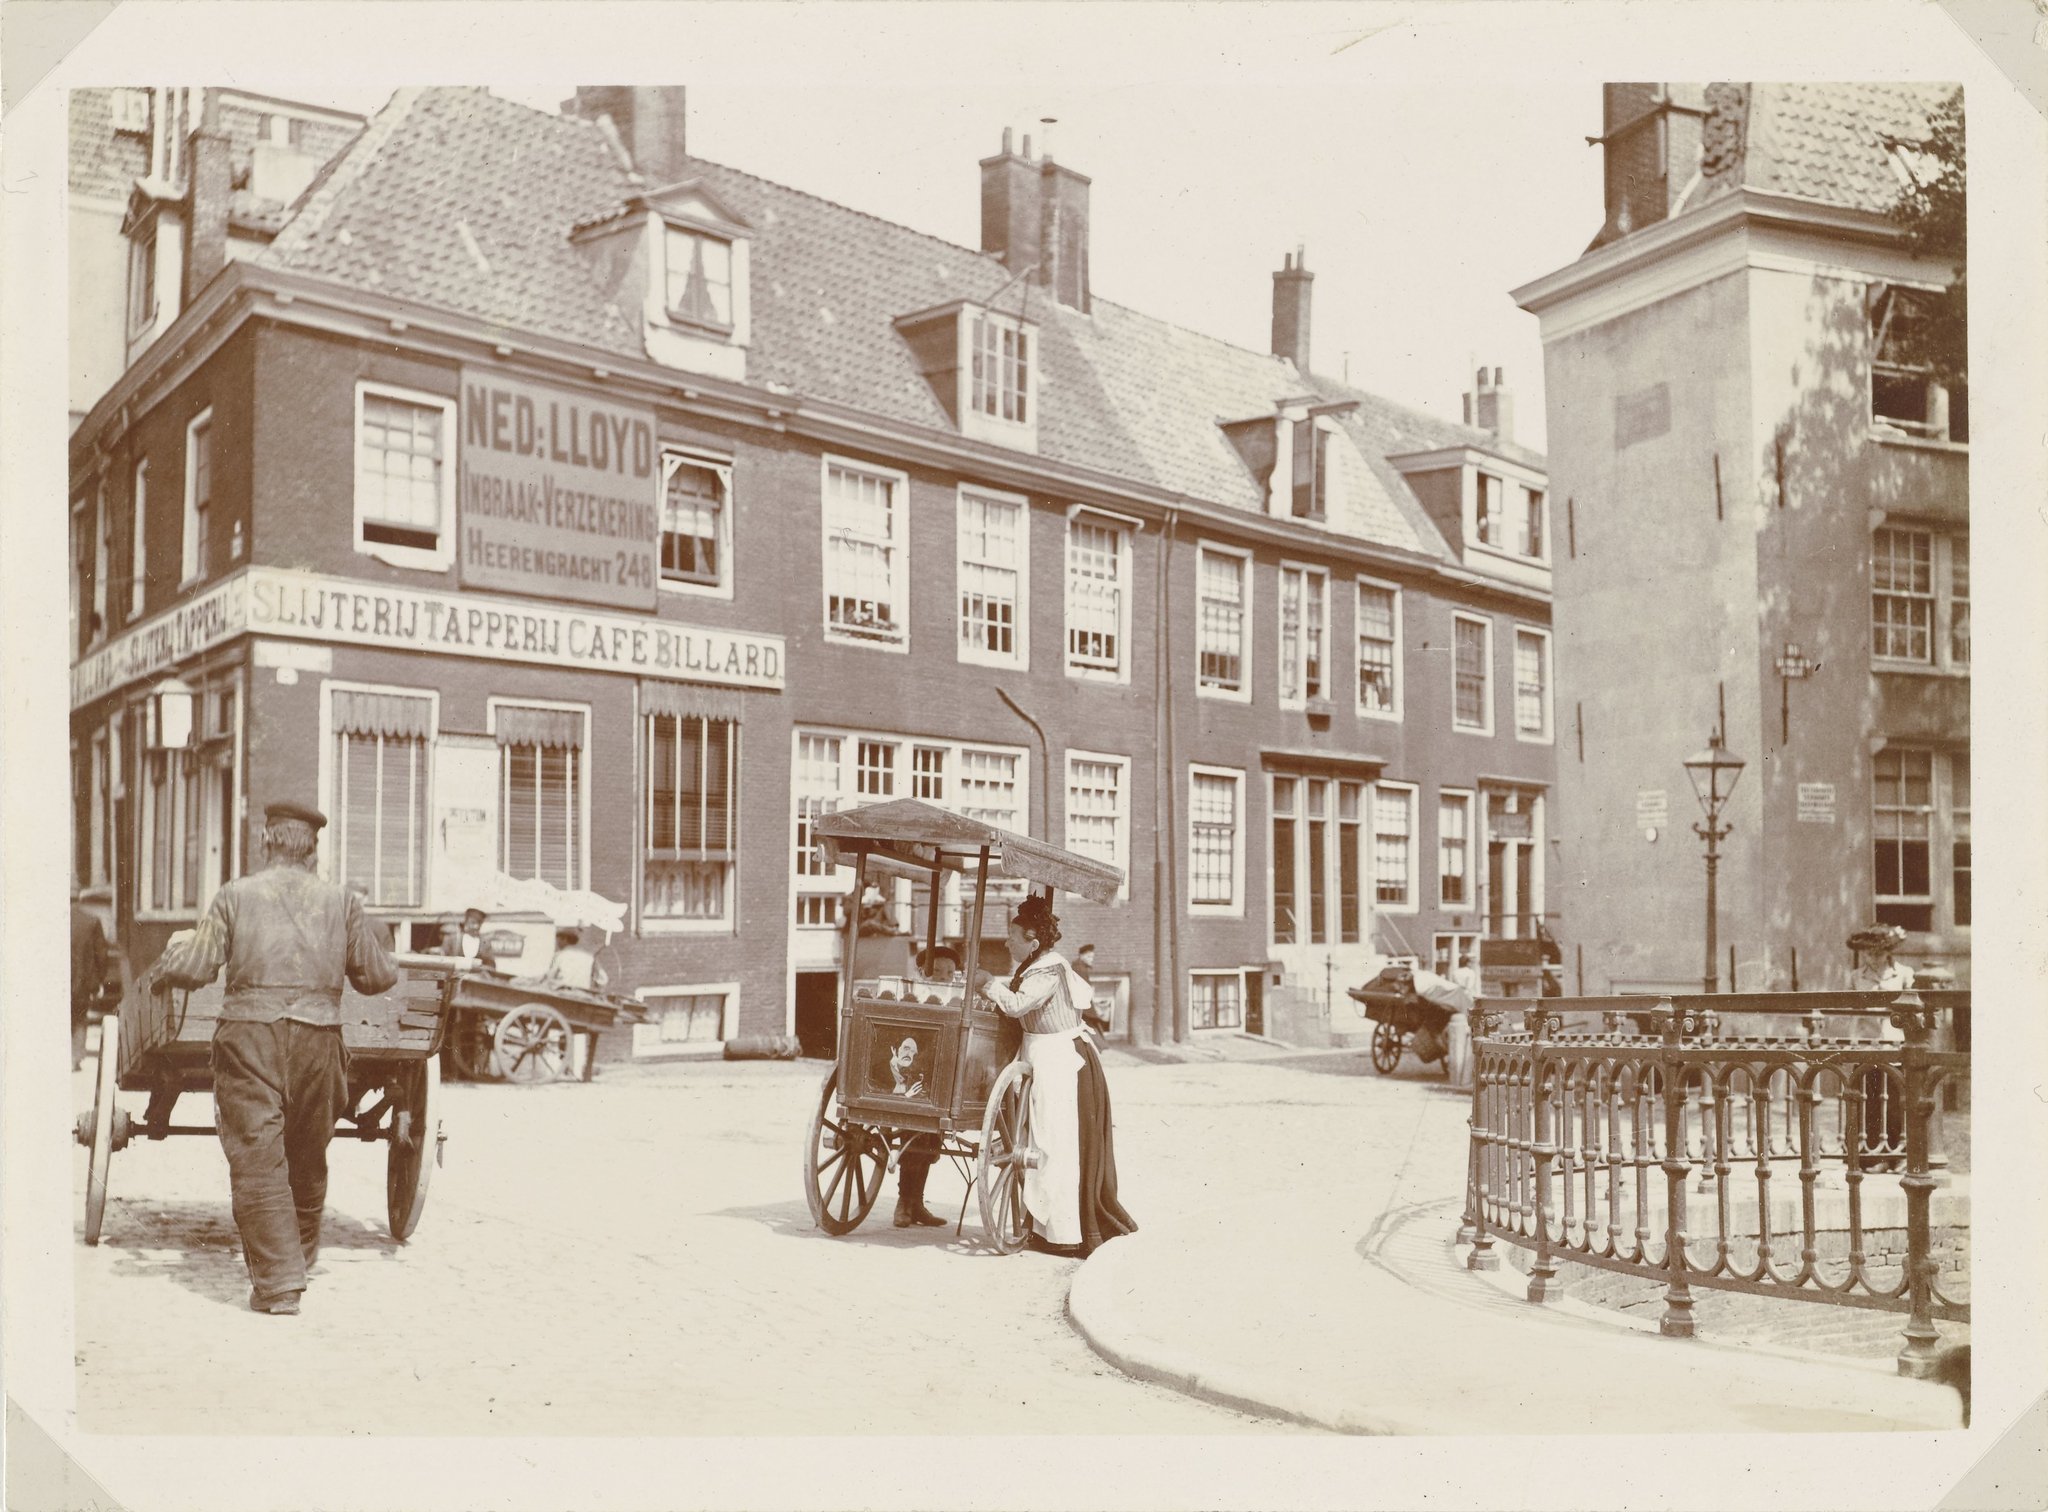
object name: photograph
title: Verkoopster en een man met een handkar op de hoek van de Lijnbaansgracht en de Spiegelgracht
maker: james higson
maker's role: politician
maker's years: 1862-1933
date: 1904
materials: paper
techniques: gelatin silver print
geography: amsterdam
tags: merchant, salesman - bb - women engaged in trade and commerce, street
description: Links de Spiegelgracht, in het midden de Tweede Weteringdwarsstraat en rechts de Lijnbaansgracht.